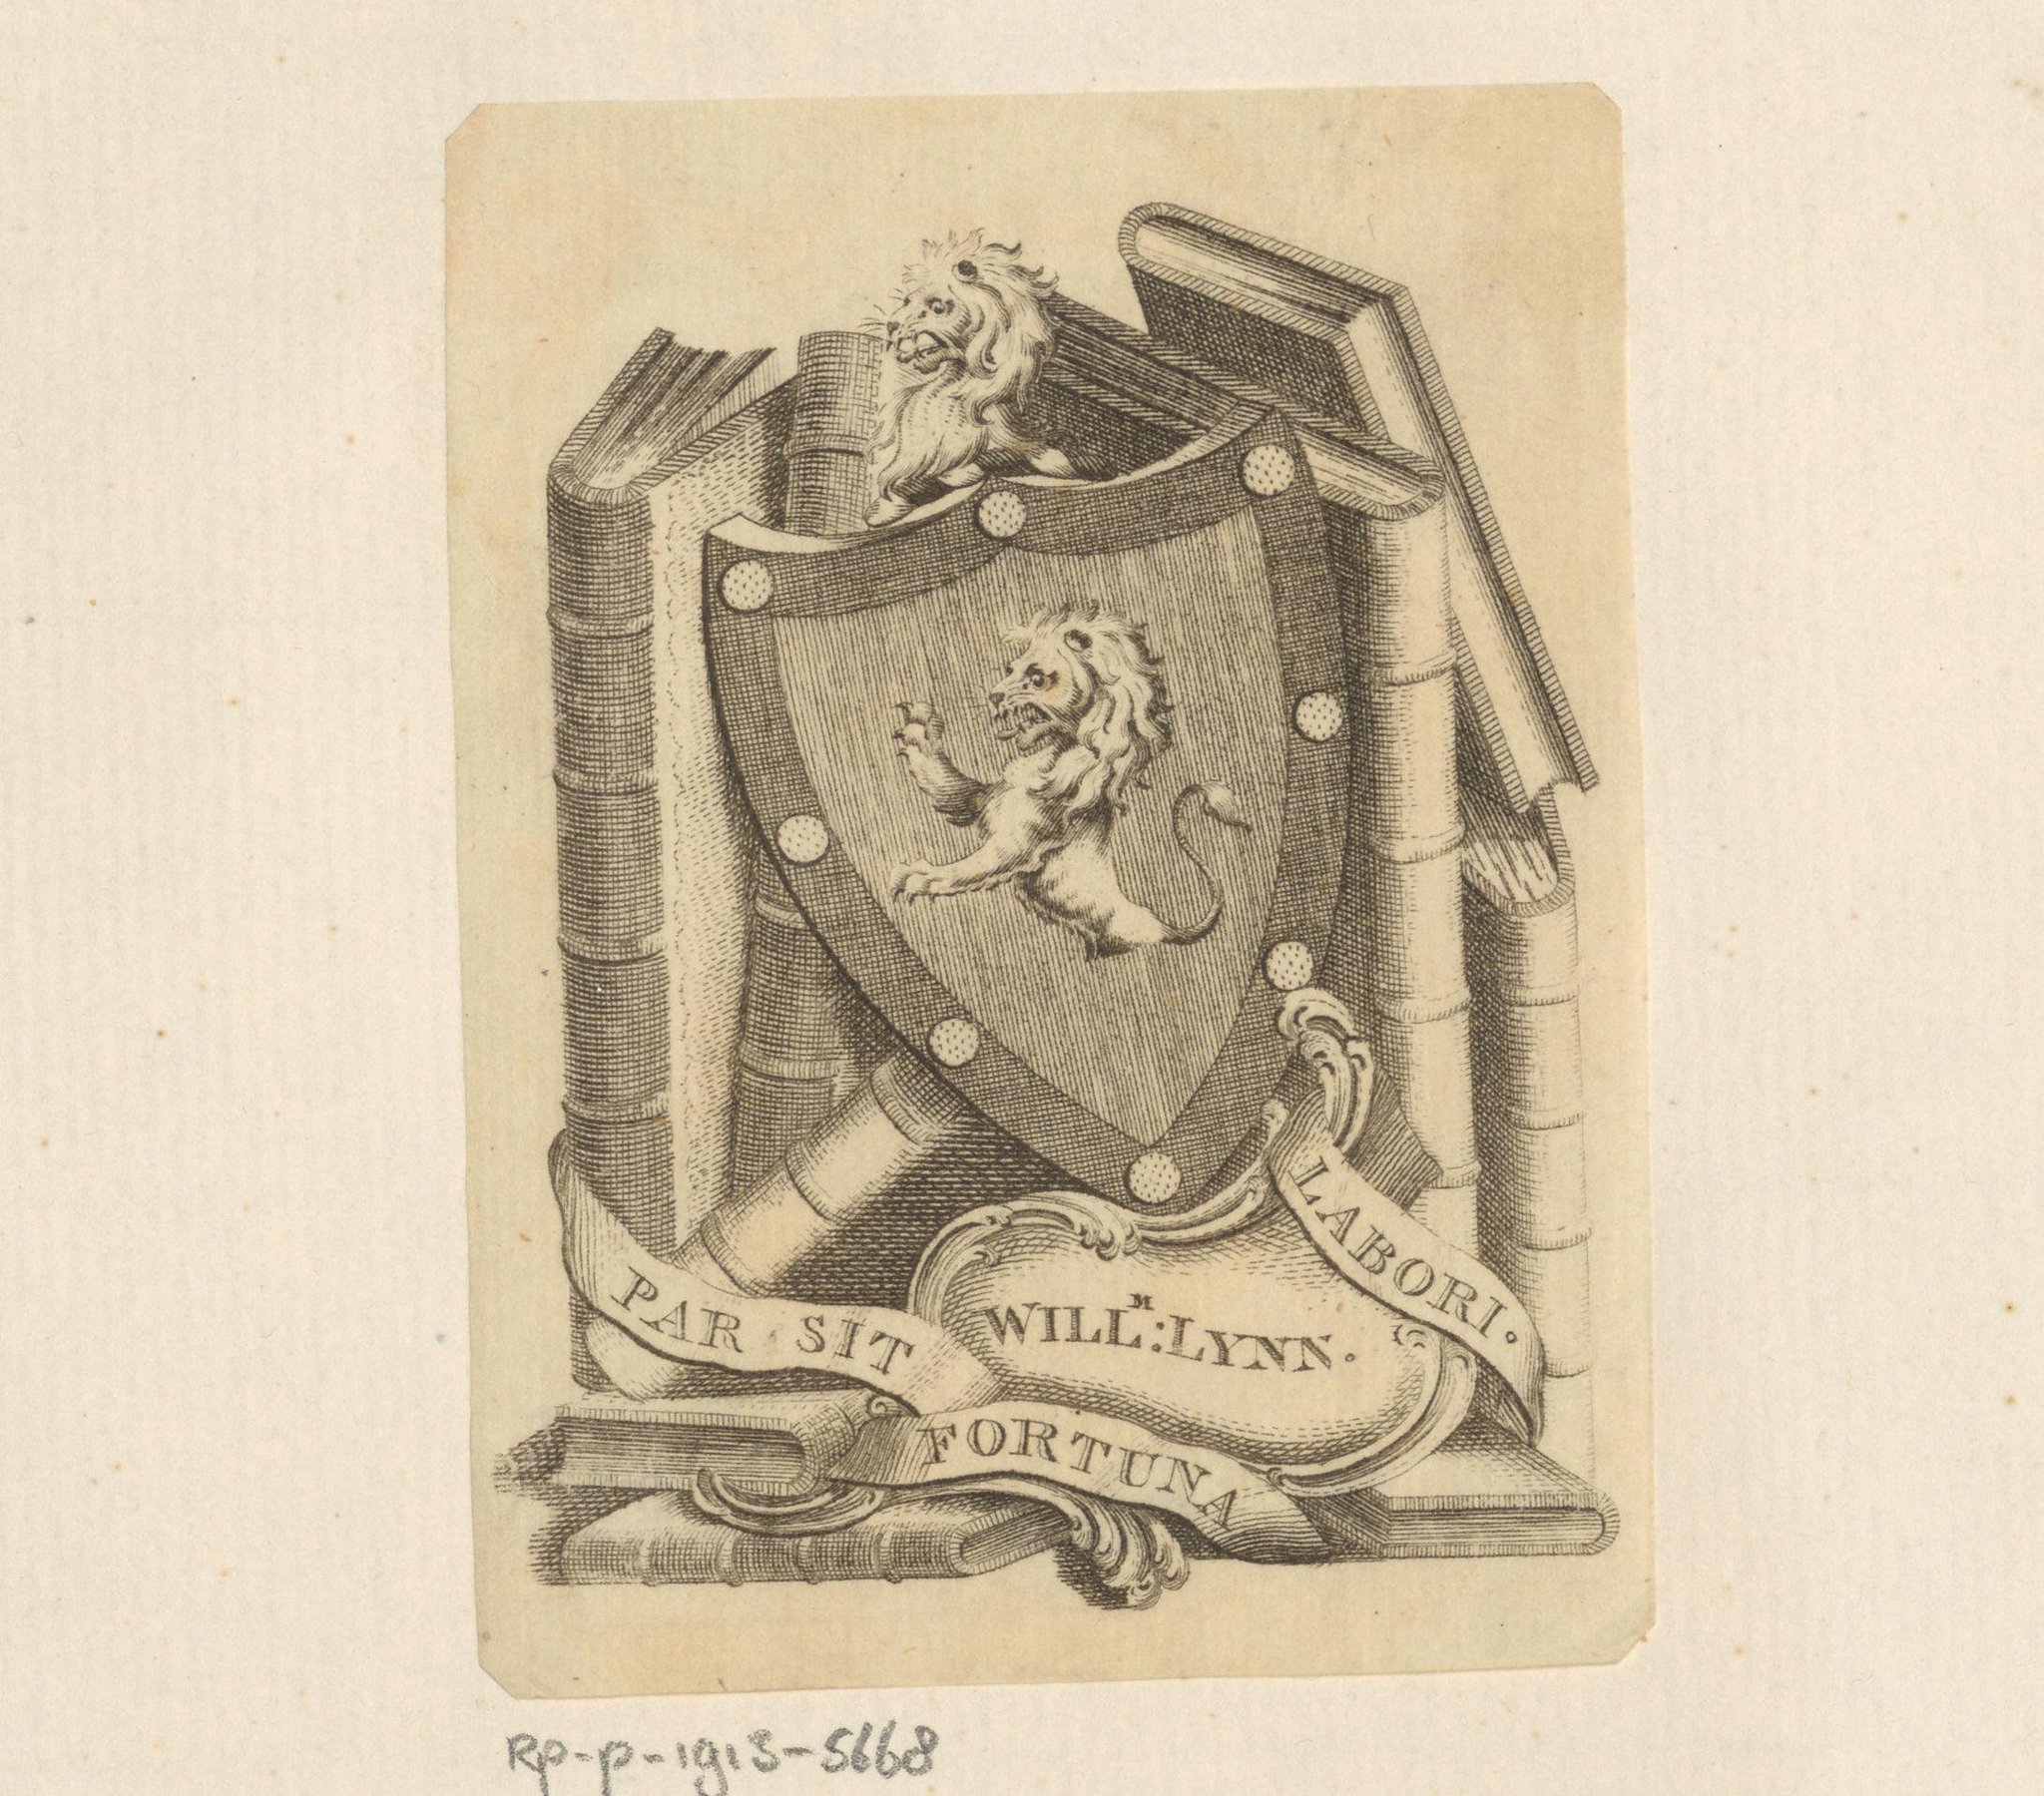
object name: bookplate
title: Par sit fortuna labori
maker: Anonymous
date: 1750-1849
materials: paper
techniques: etching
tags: book, armorial bearing, heraldry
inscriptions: collector's mark: Lugt 2760, collector's mark: Lugt 2233